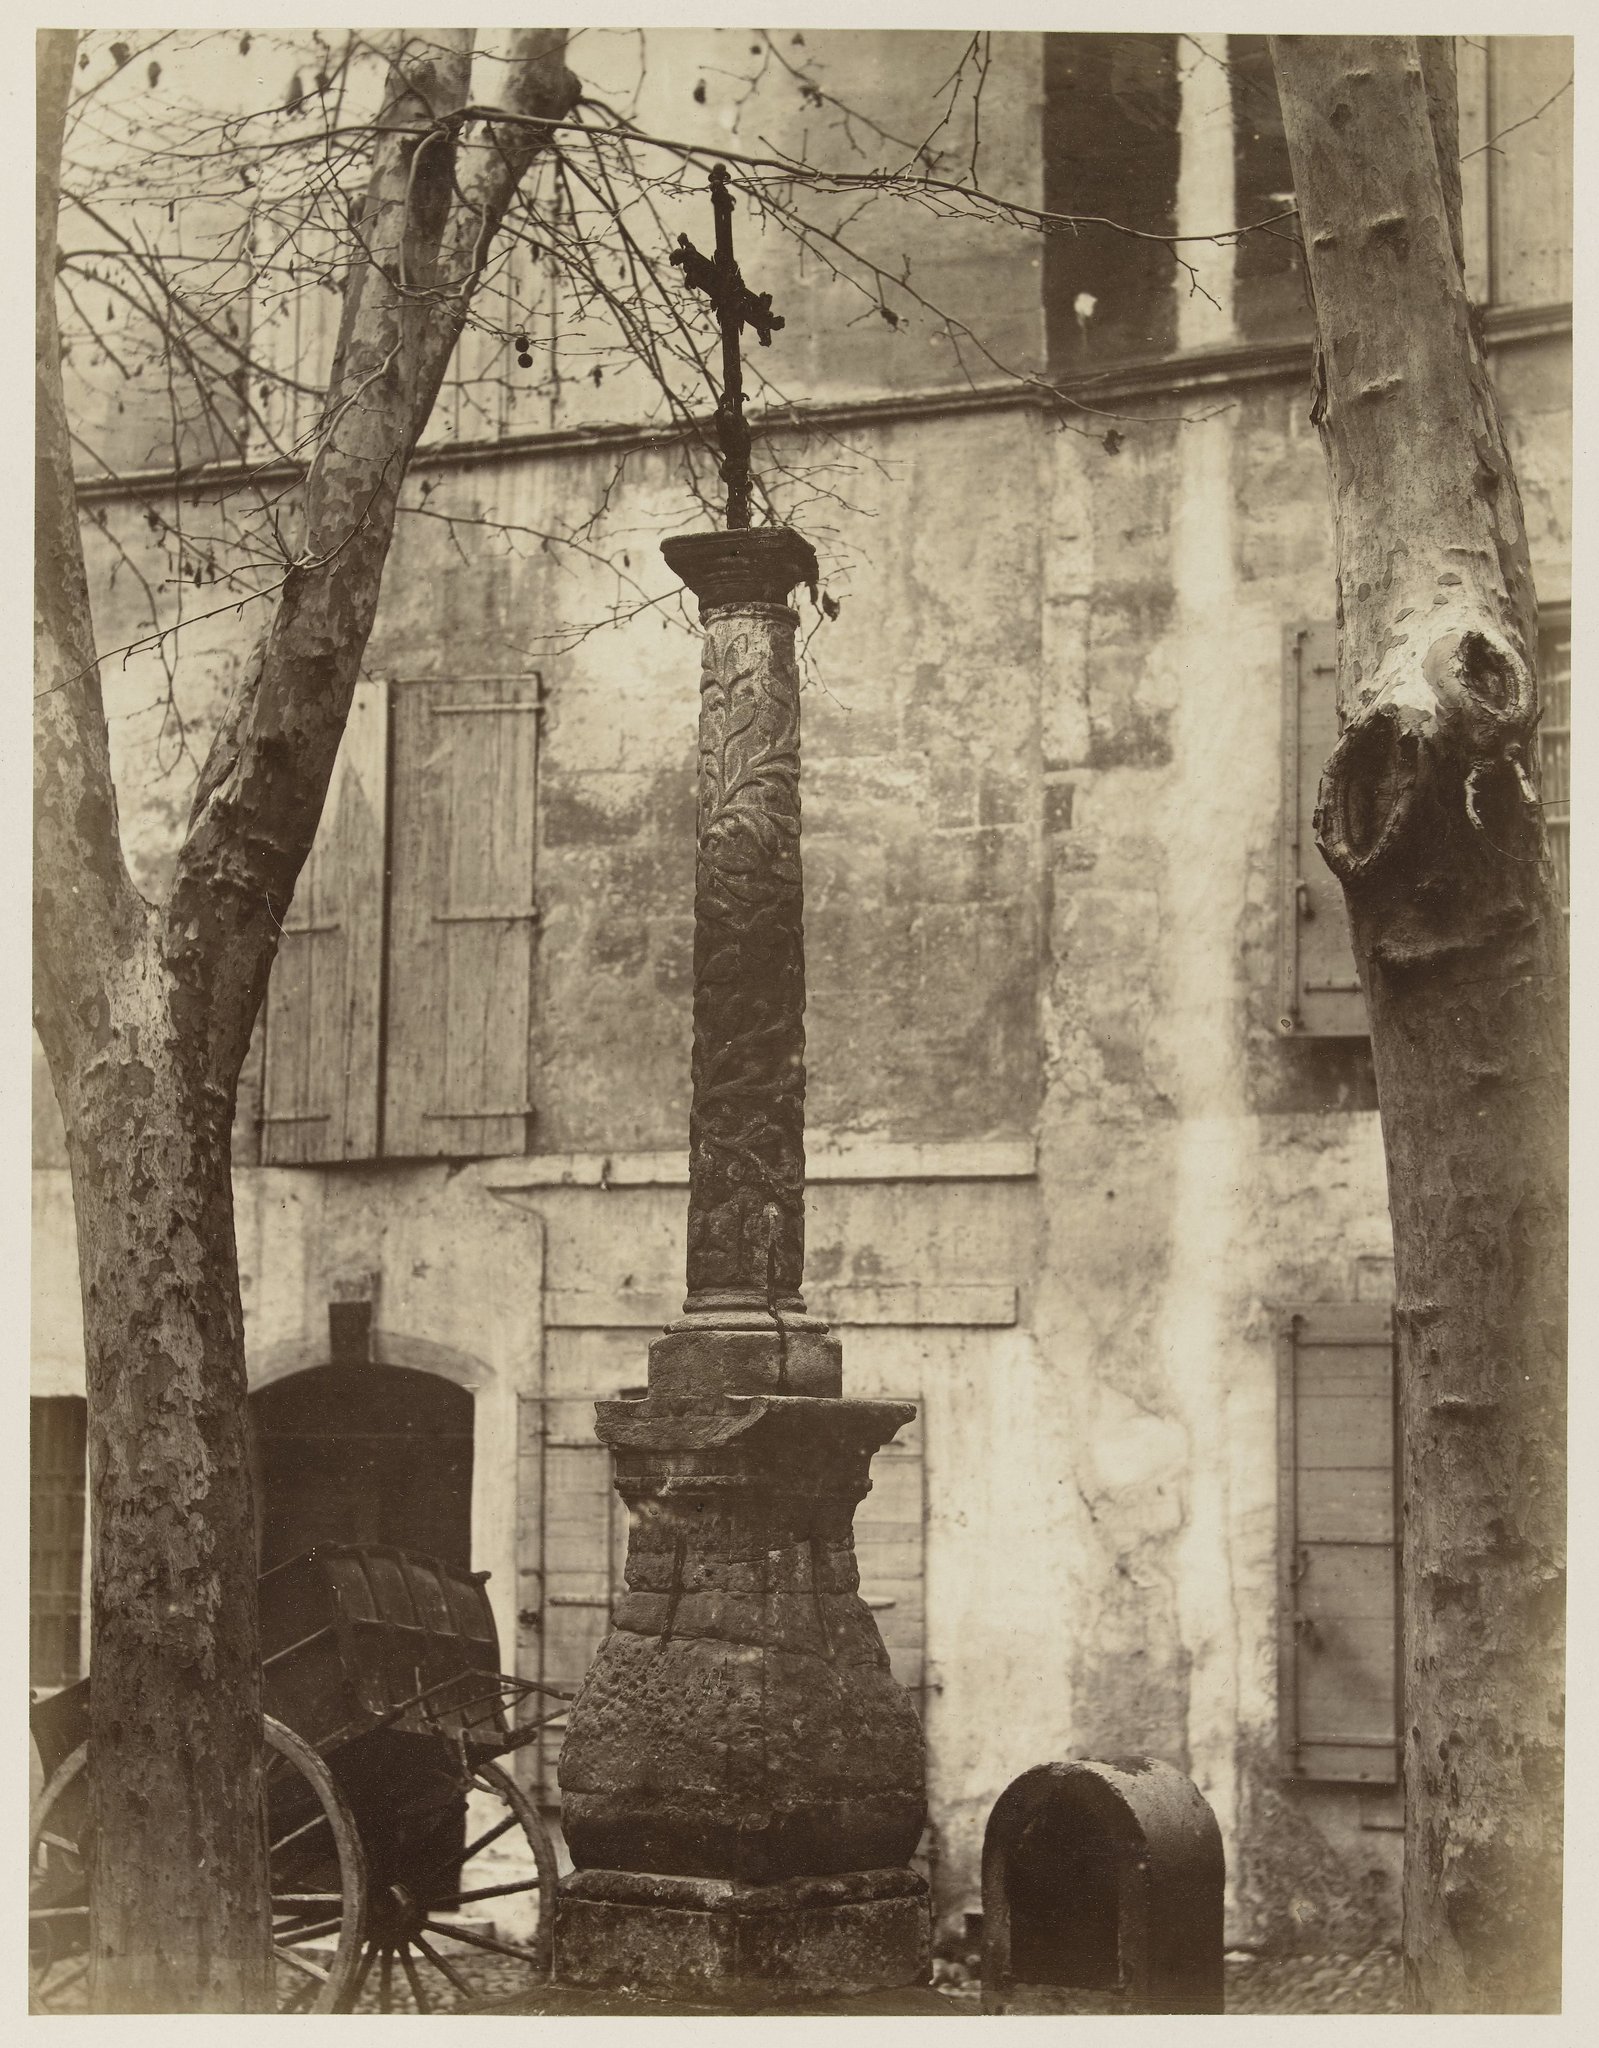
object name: photograph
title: Arles, croix sur la place, Bouches du Rhone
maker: charles lenormand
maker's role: fotograaf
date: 1875-1885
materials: cardboard, paper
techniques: albumen print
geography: arles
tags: market cross, monument, statue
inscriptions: stamp: ‘Ch. Lenormand Phot.’